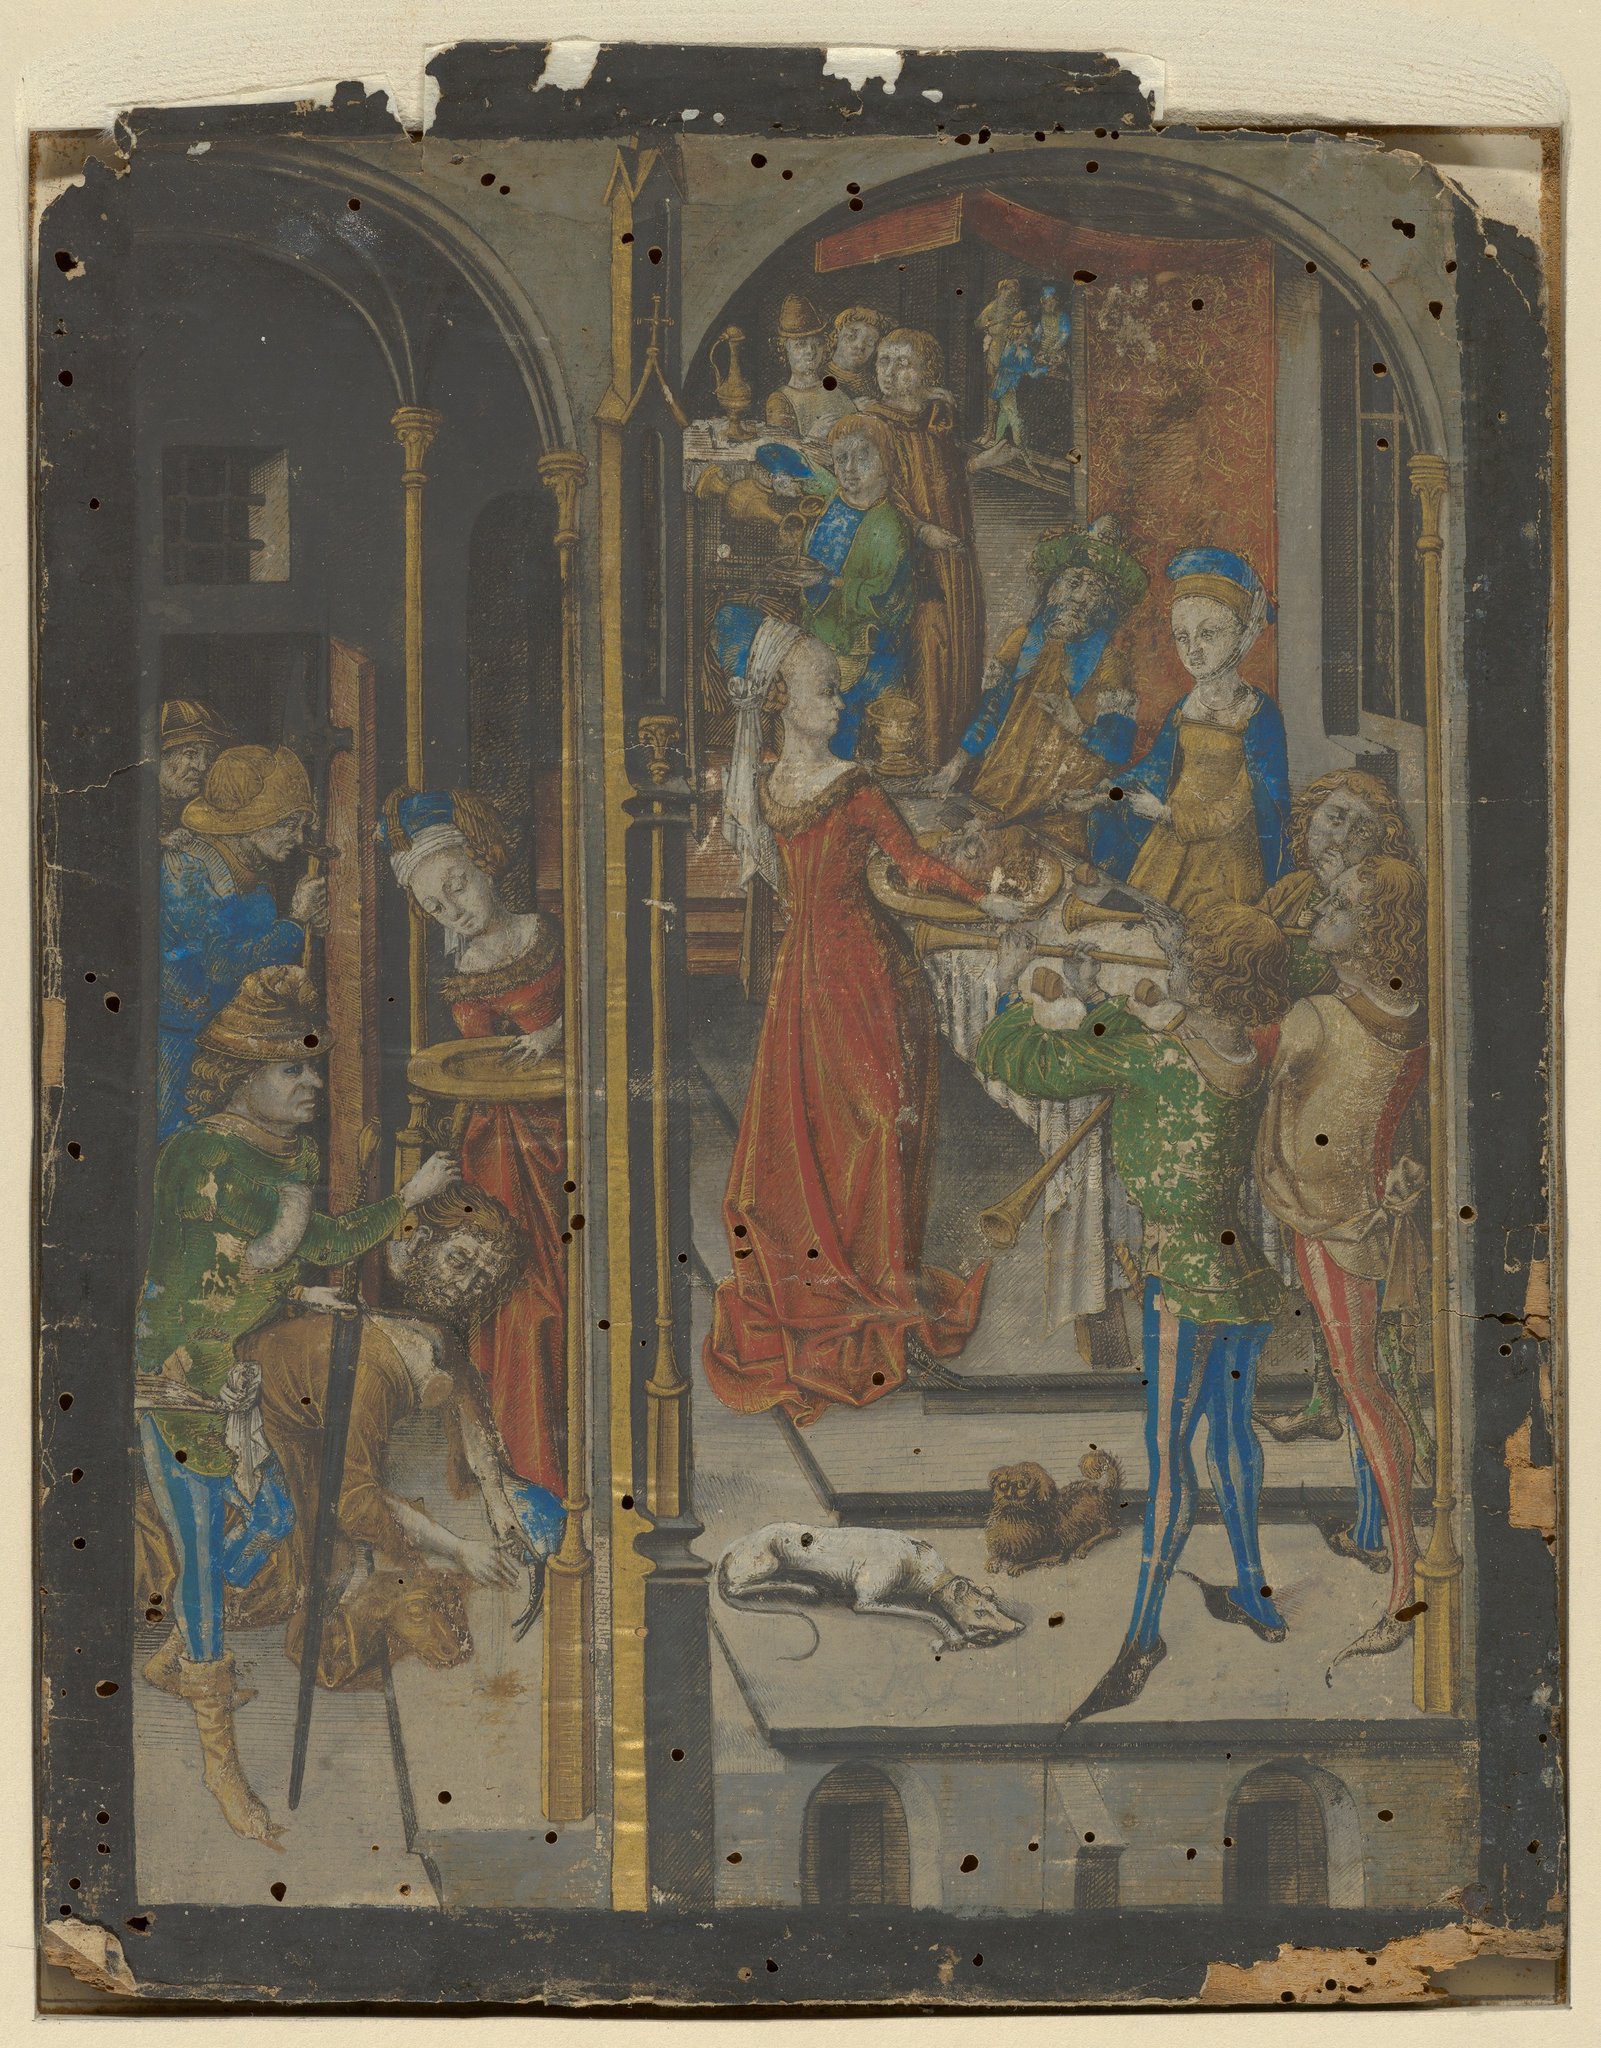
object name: print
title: The Beheading of St. John the Baptist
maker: israhel van meckenem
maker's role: artist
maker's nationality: german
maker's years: 1435-1503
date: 1490-1500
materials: wood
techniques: engraving, hand coloring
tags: men,women,dogs,saint john the baptist,musicians